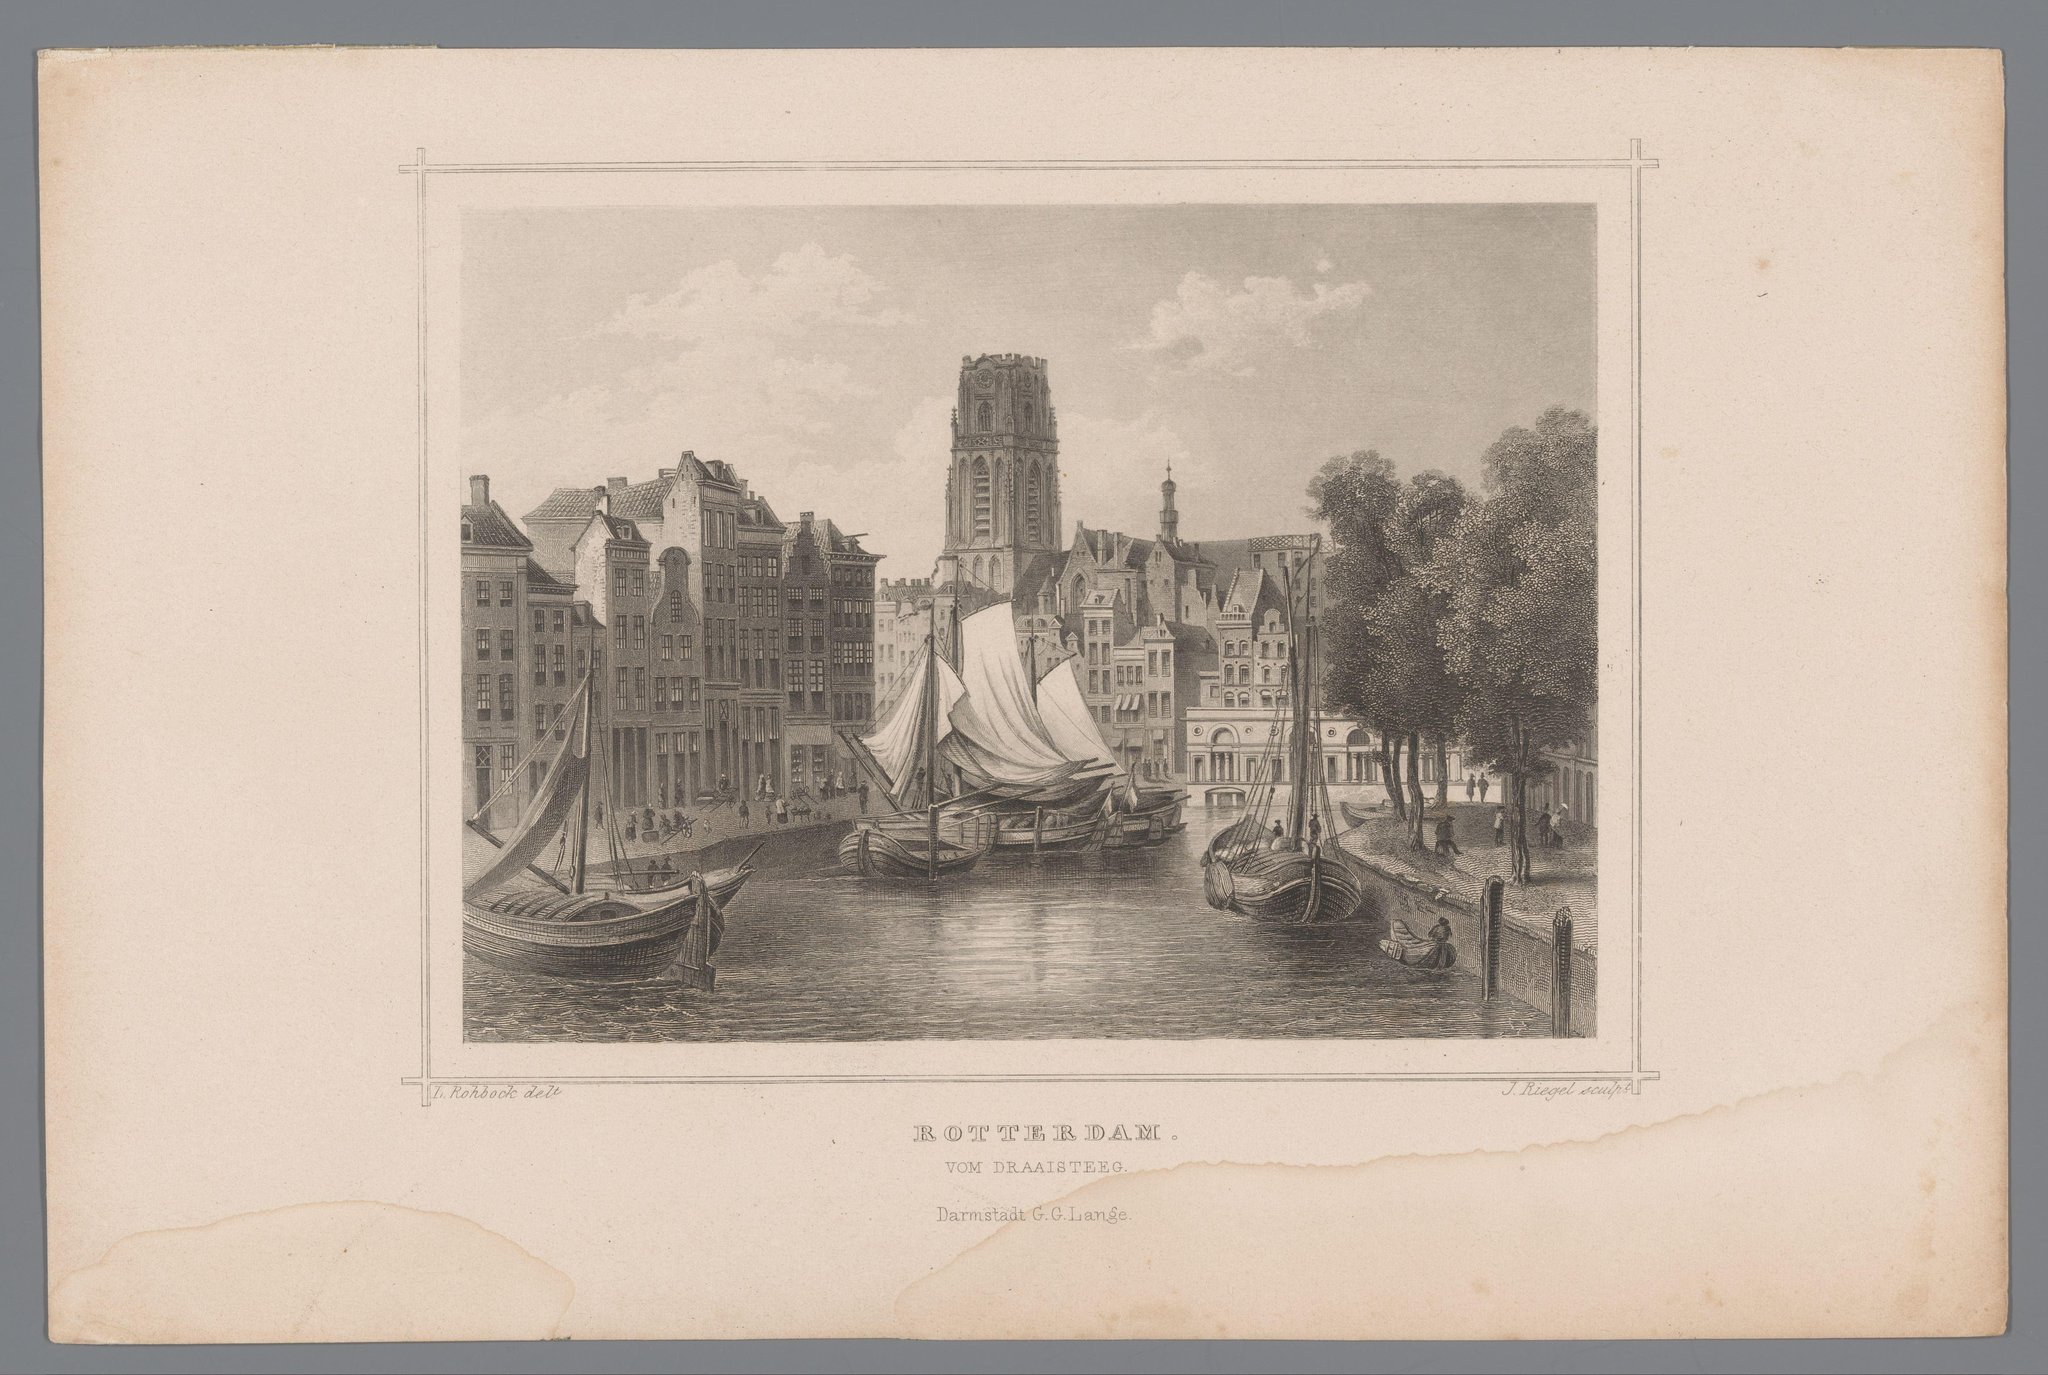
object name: book illustration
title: Rotterdam. Vom Draaisteeg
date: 1863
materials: paper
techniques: engraving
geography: darmstadt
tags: sailing-ship, sailing-boat, church (exterior), canals, waters (in city), rotterdam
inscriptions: collector's mark: Lugt 2233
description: Prent uit: Der Rhein und die Rheinlande in malerischen Original-ansichten. 3 dln. Darmstadt: G.G. Lange, 1863, dl. 3, p. 156-157. Dezelfde prent, met een ander onderschrift, komt ook voor in: Terwen, J.L. Het koningrijk der Nederlanden (...). 2 dln. Gouda: G.B. van Goor, 1857, p. 266-267.